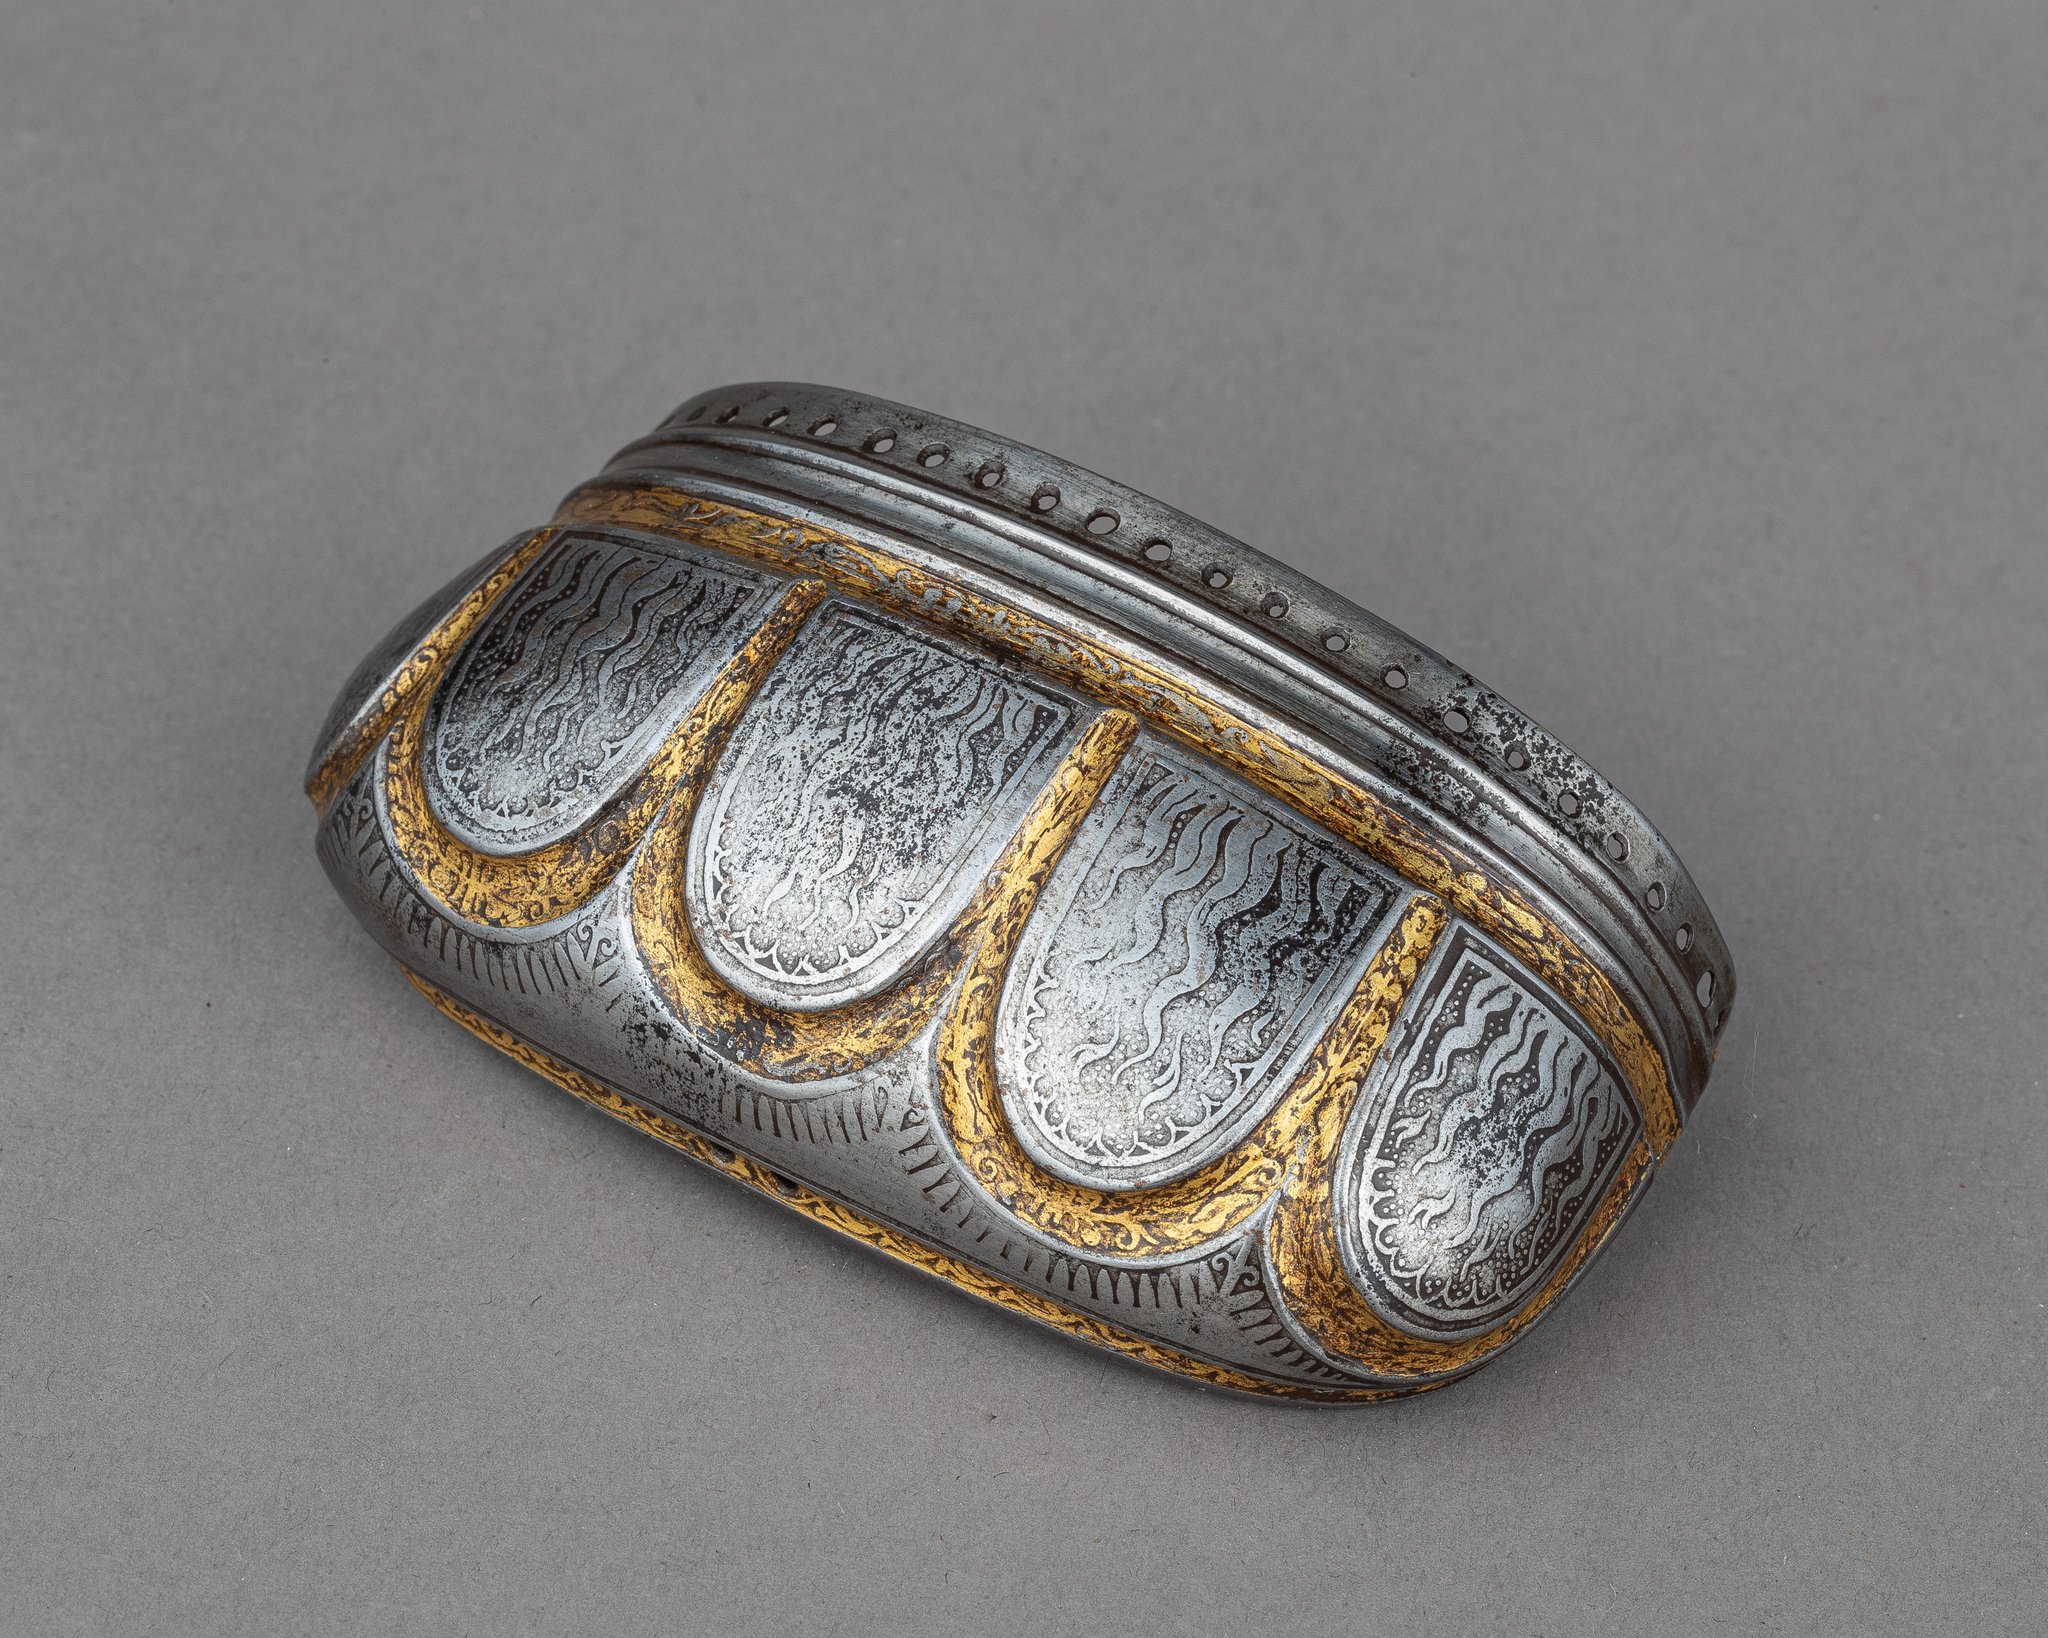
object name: toe cap for a foot defense sabaton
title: Toe Cap for a Foot Defense (Sabaton)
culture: german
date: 1520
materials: gold, steel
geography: germany